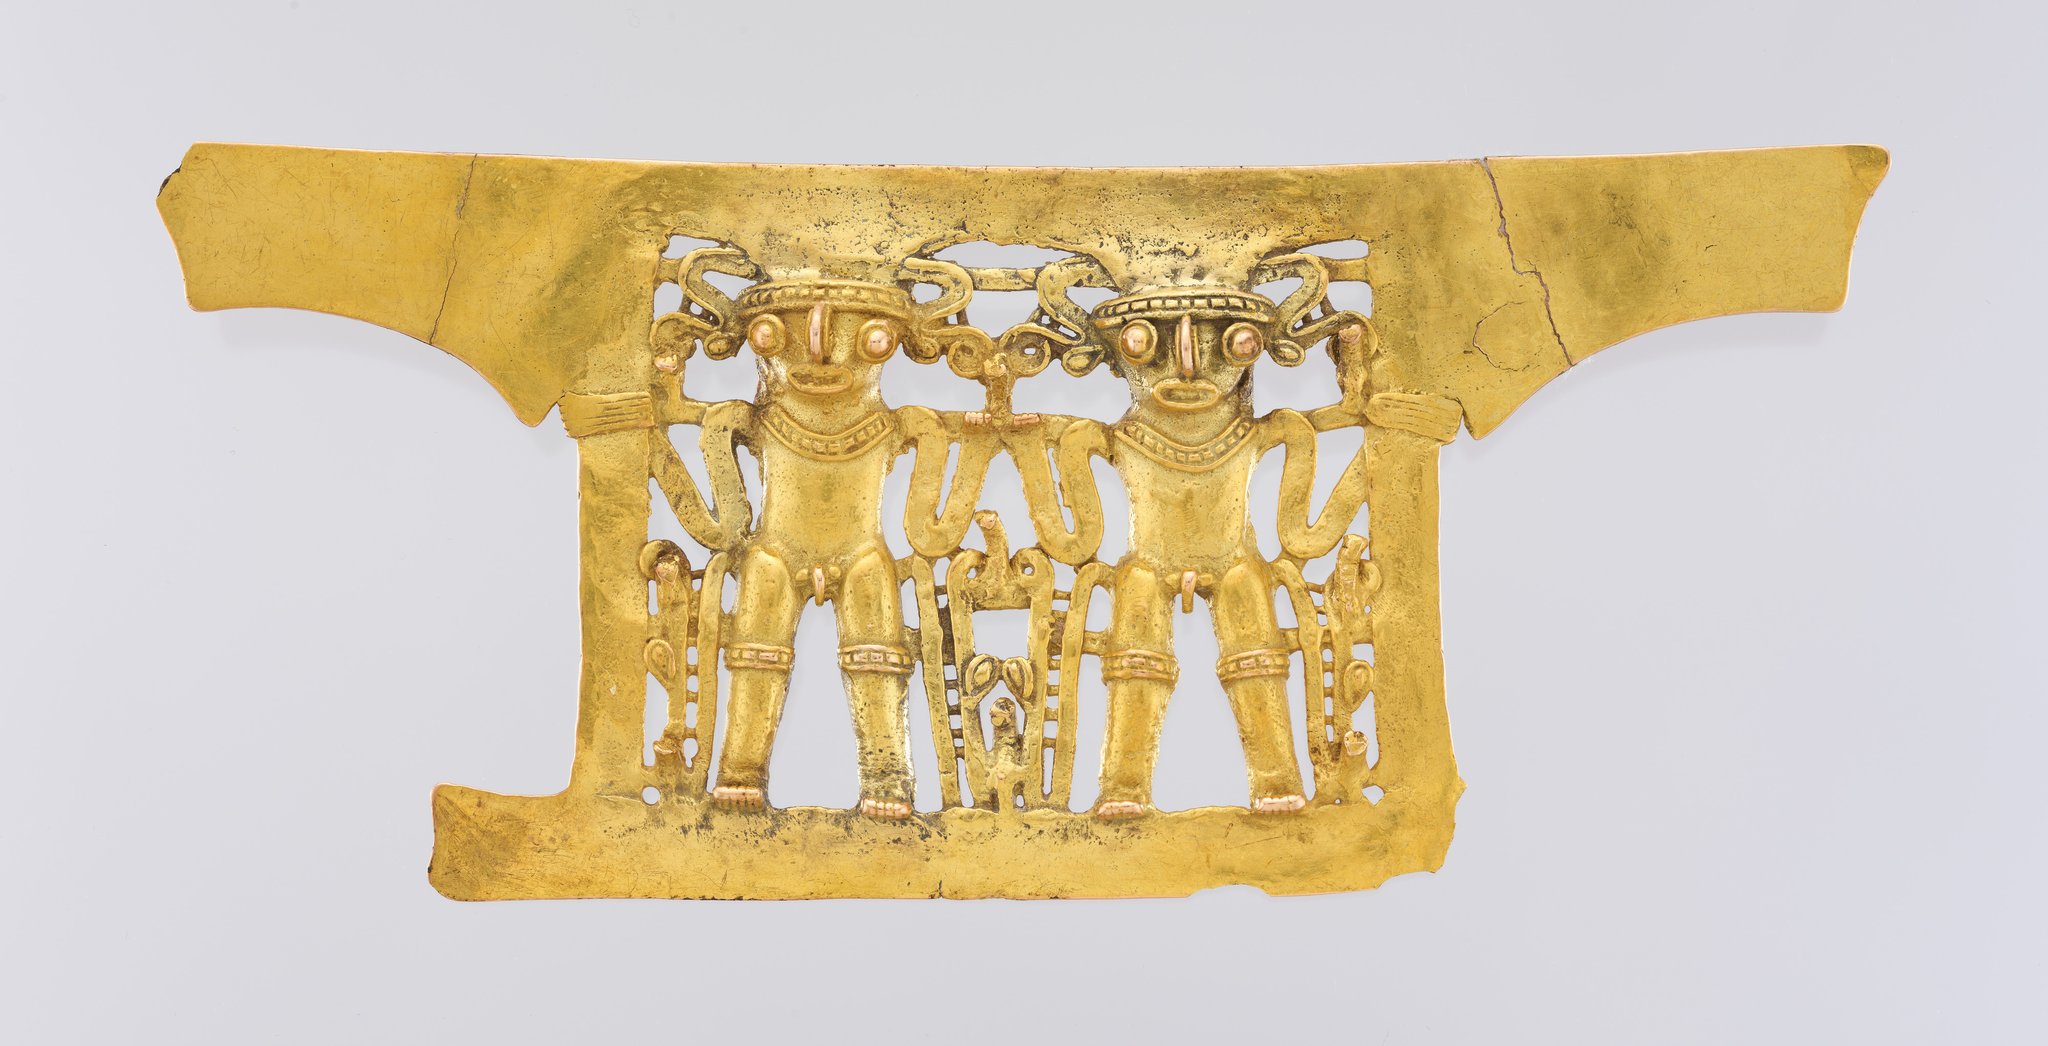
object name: pendant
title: Double Bat-Head Figure Pendant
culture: diquís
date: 1201-1600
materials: gold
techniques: casting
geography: costa rica